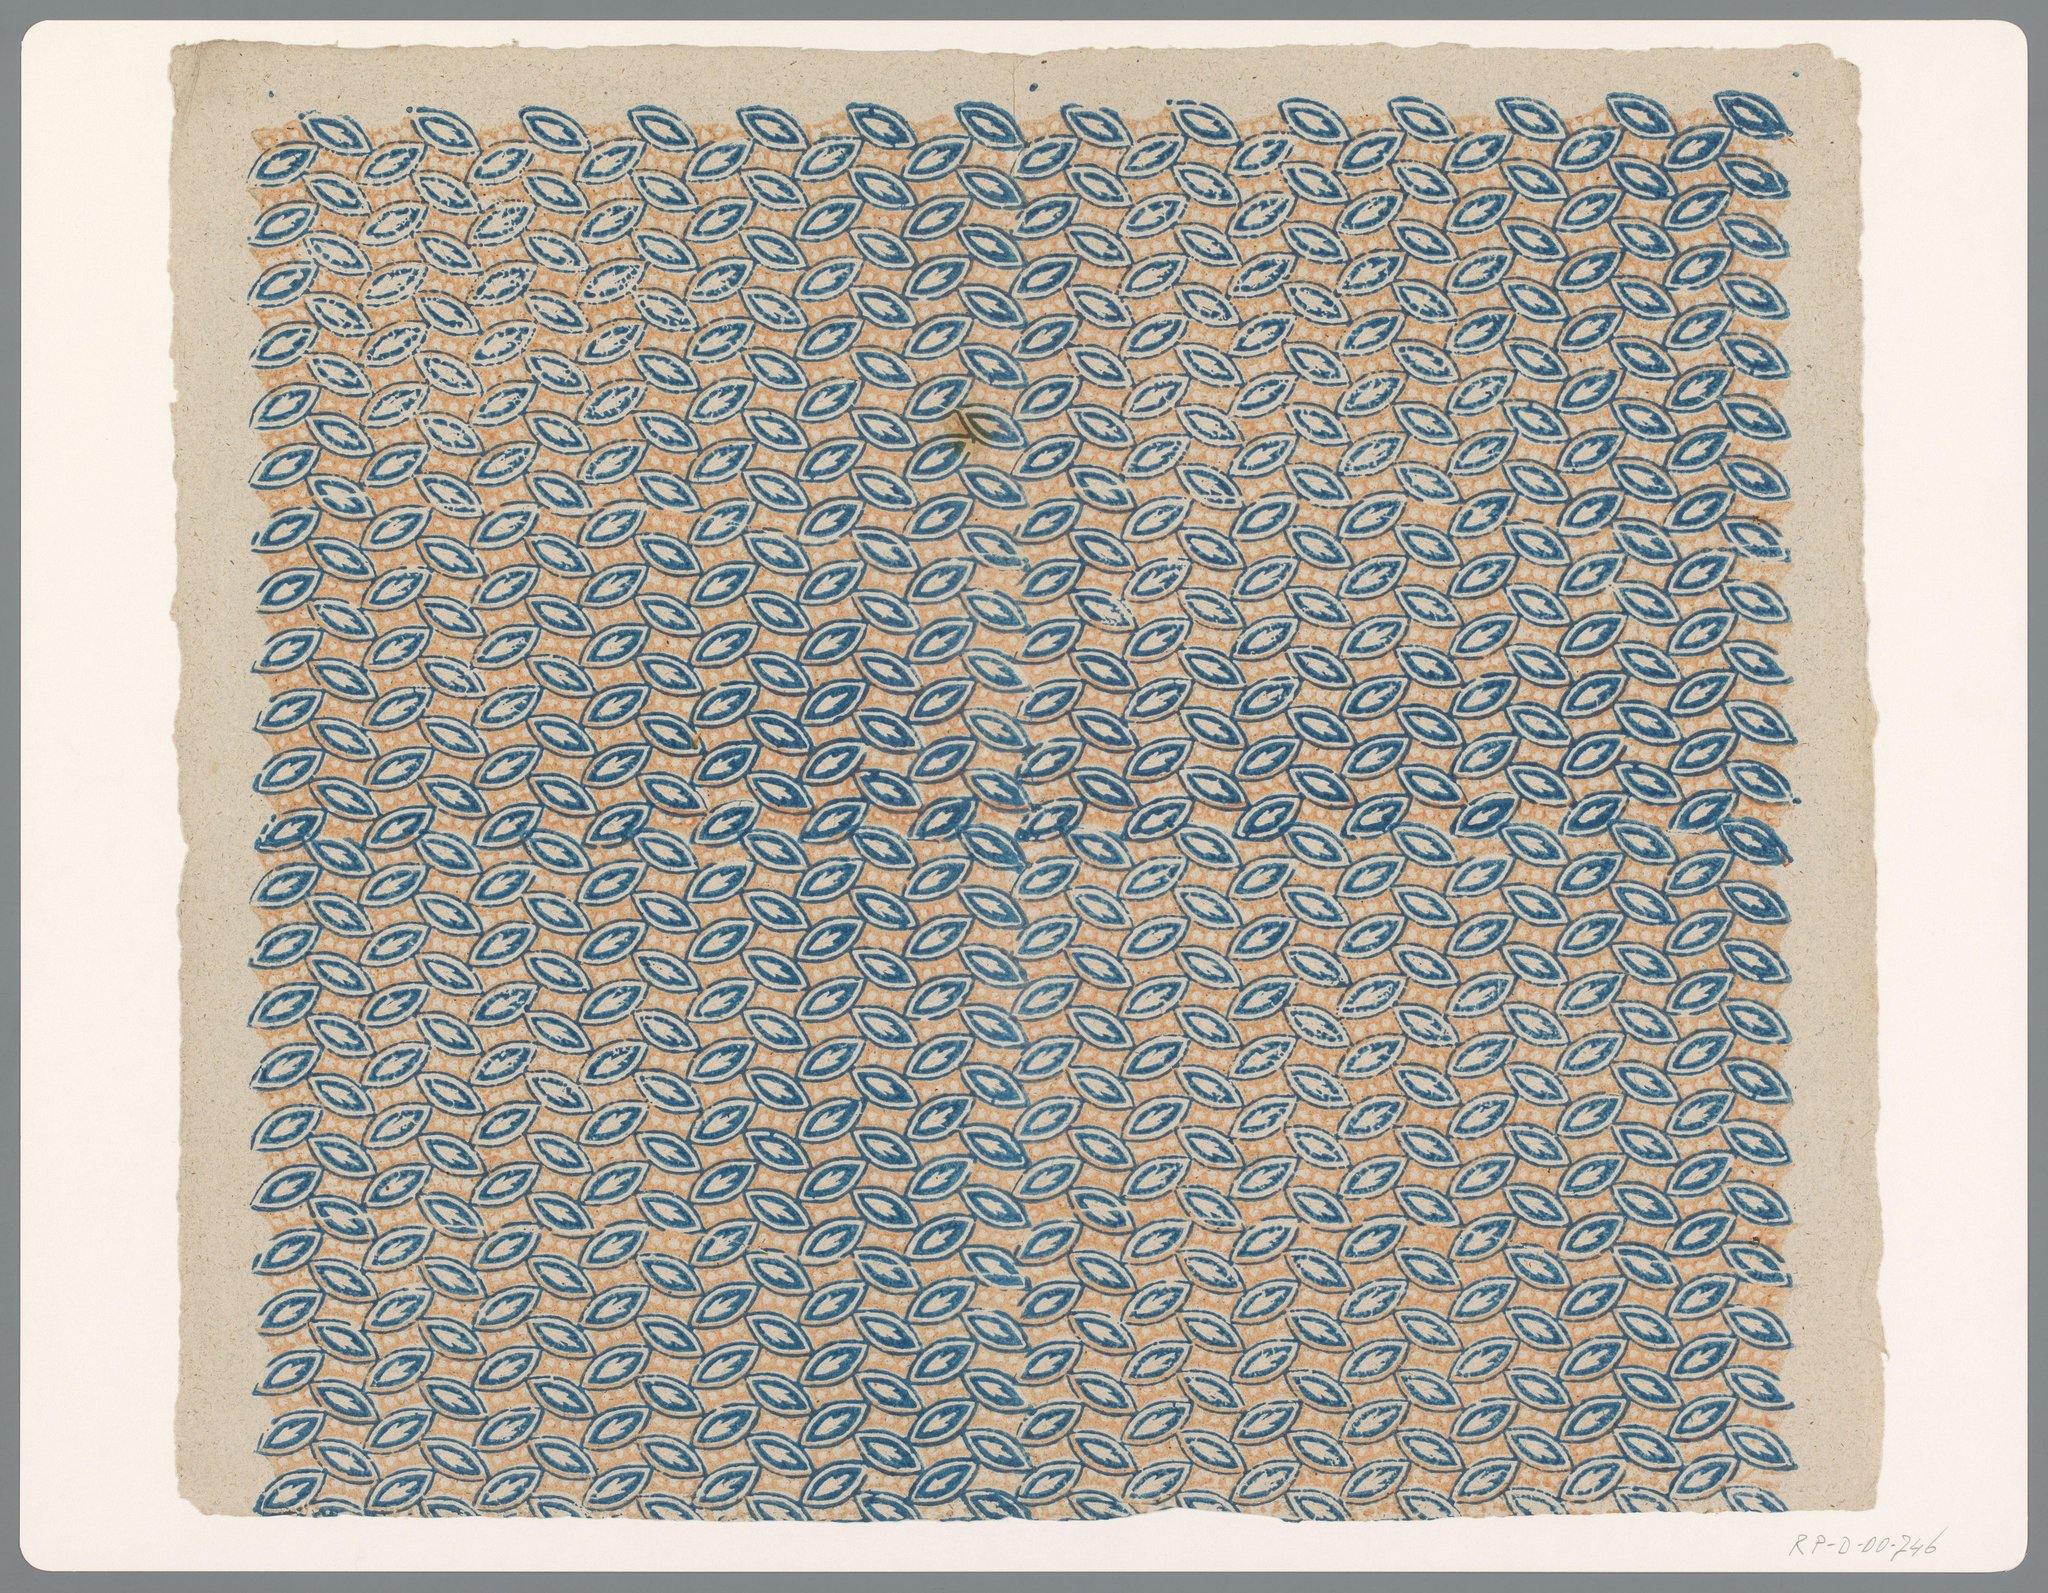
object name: printed paper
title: Blad met strooipatroon van ovaal bladmotief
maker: Anonymous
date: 1750-1950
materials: paper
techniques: printing block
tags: ornament derived from plant forms